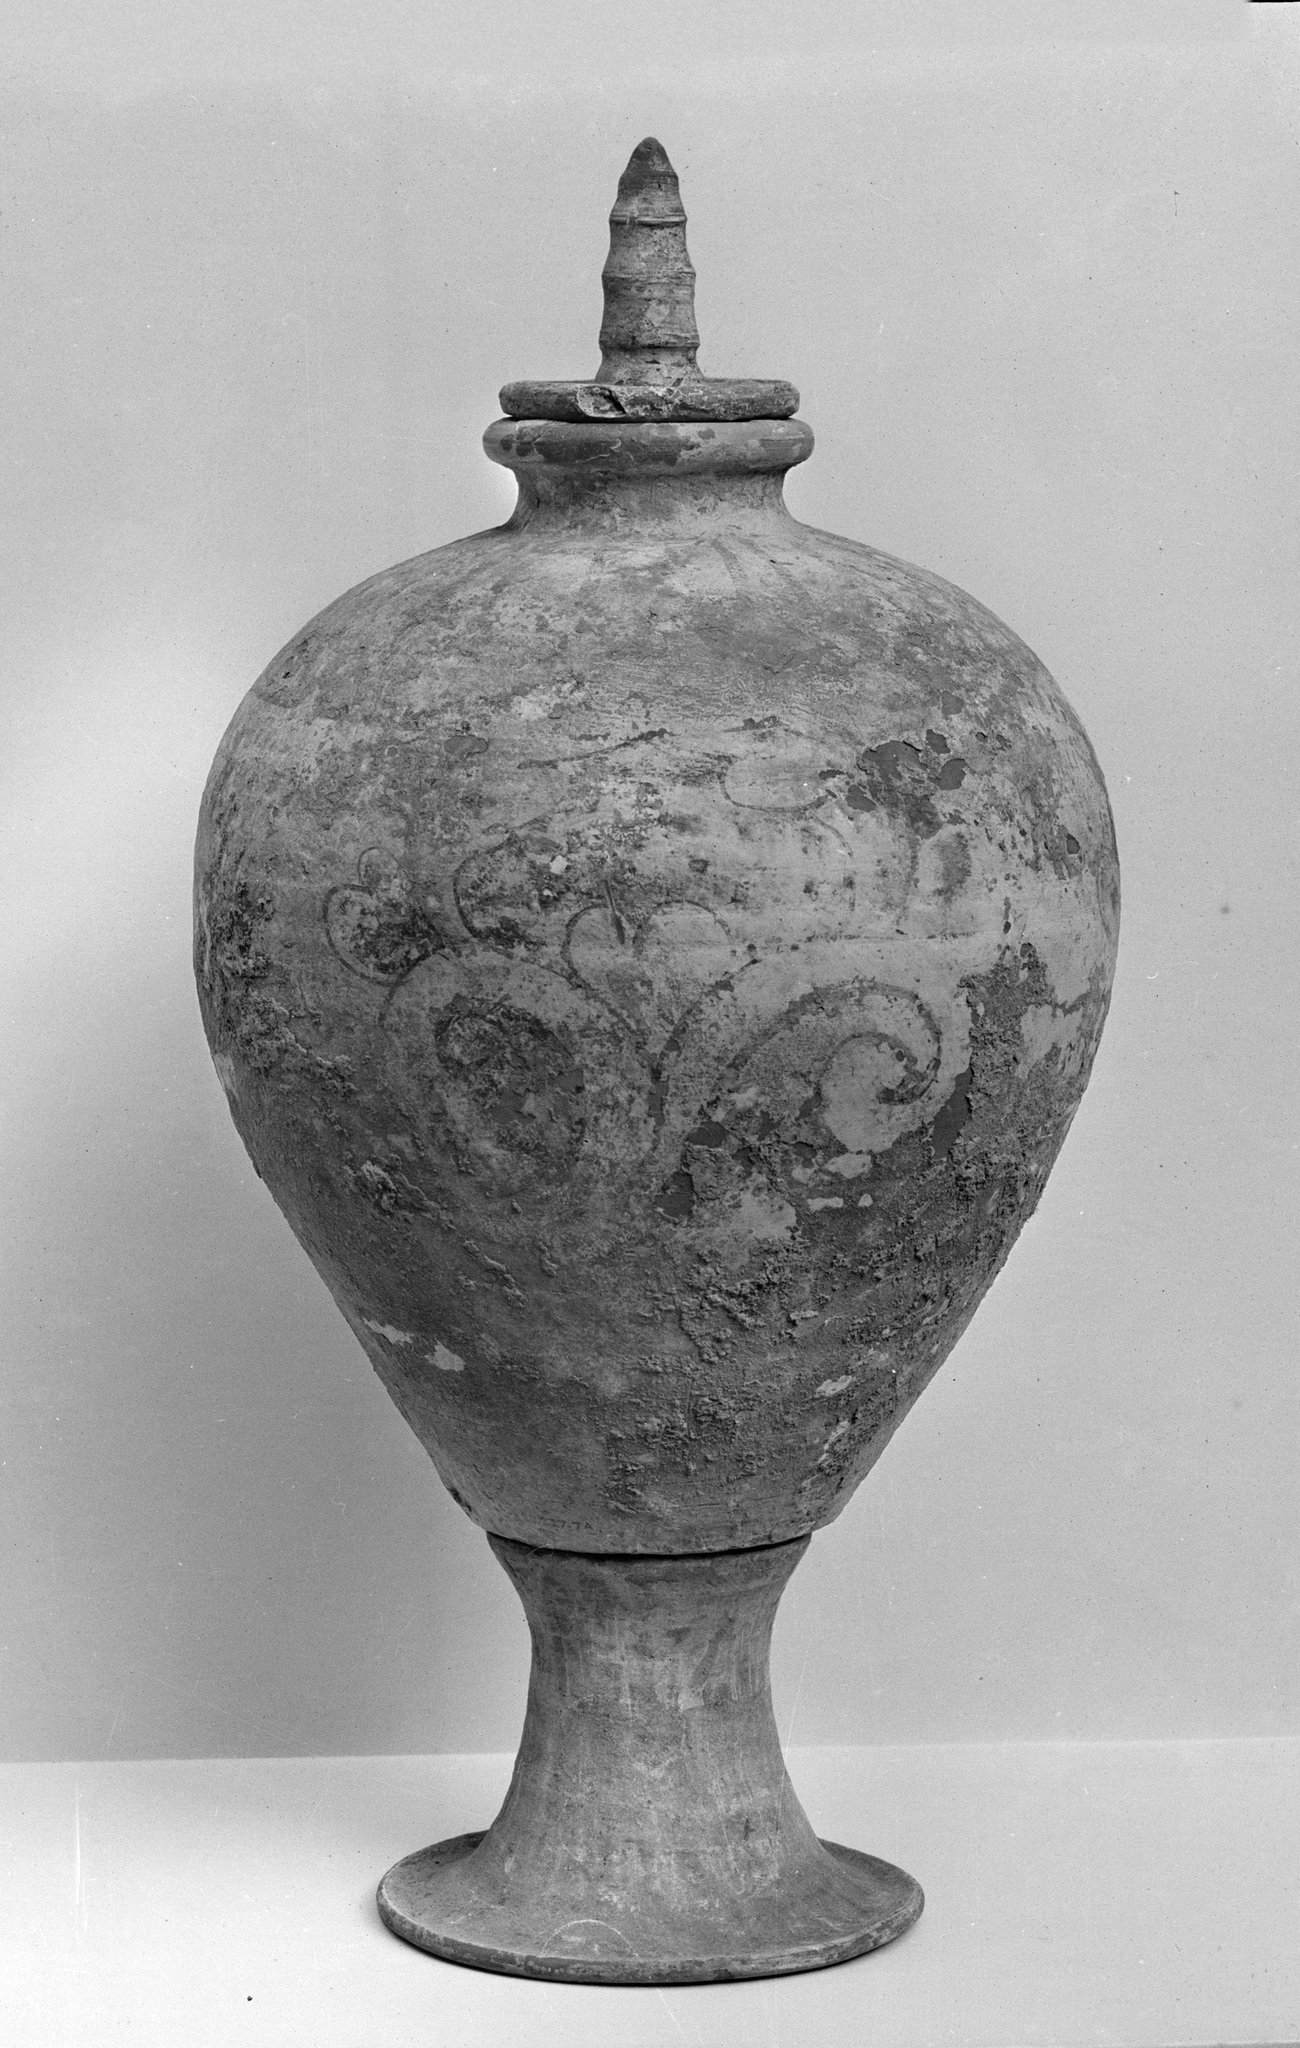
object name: covered jar on stand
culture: chinese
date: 618-907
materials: earthenware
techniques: painting